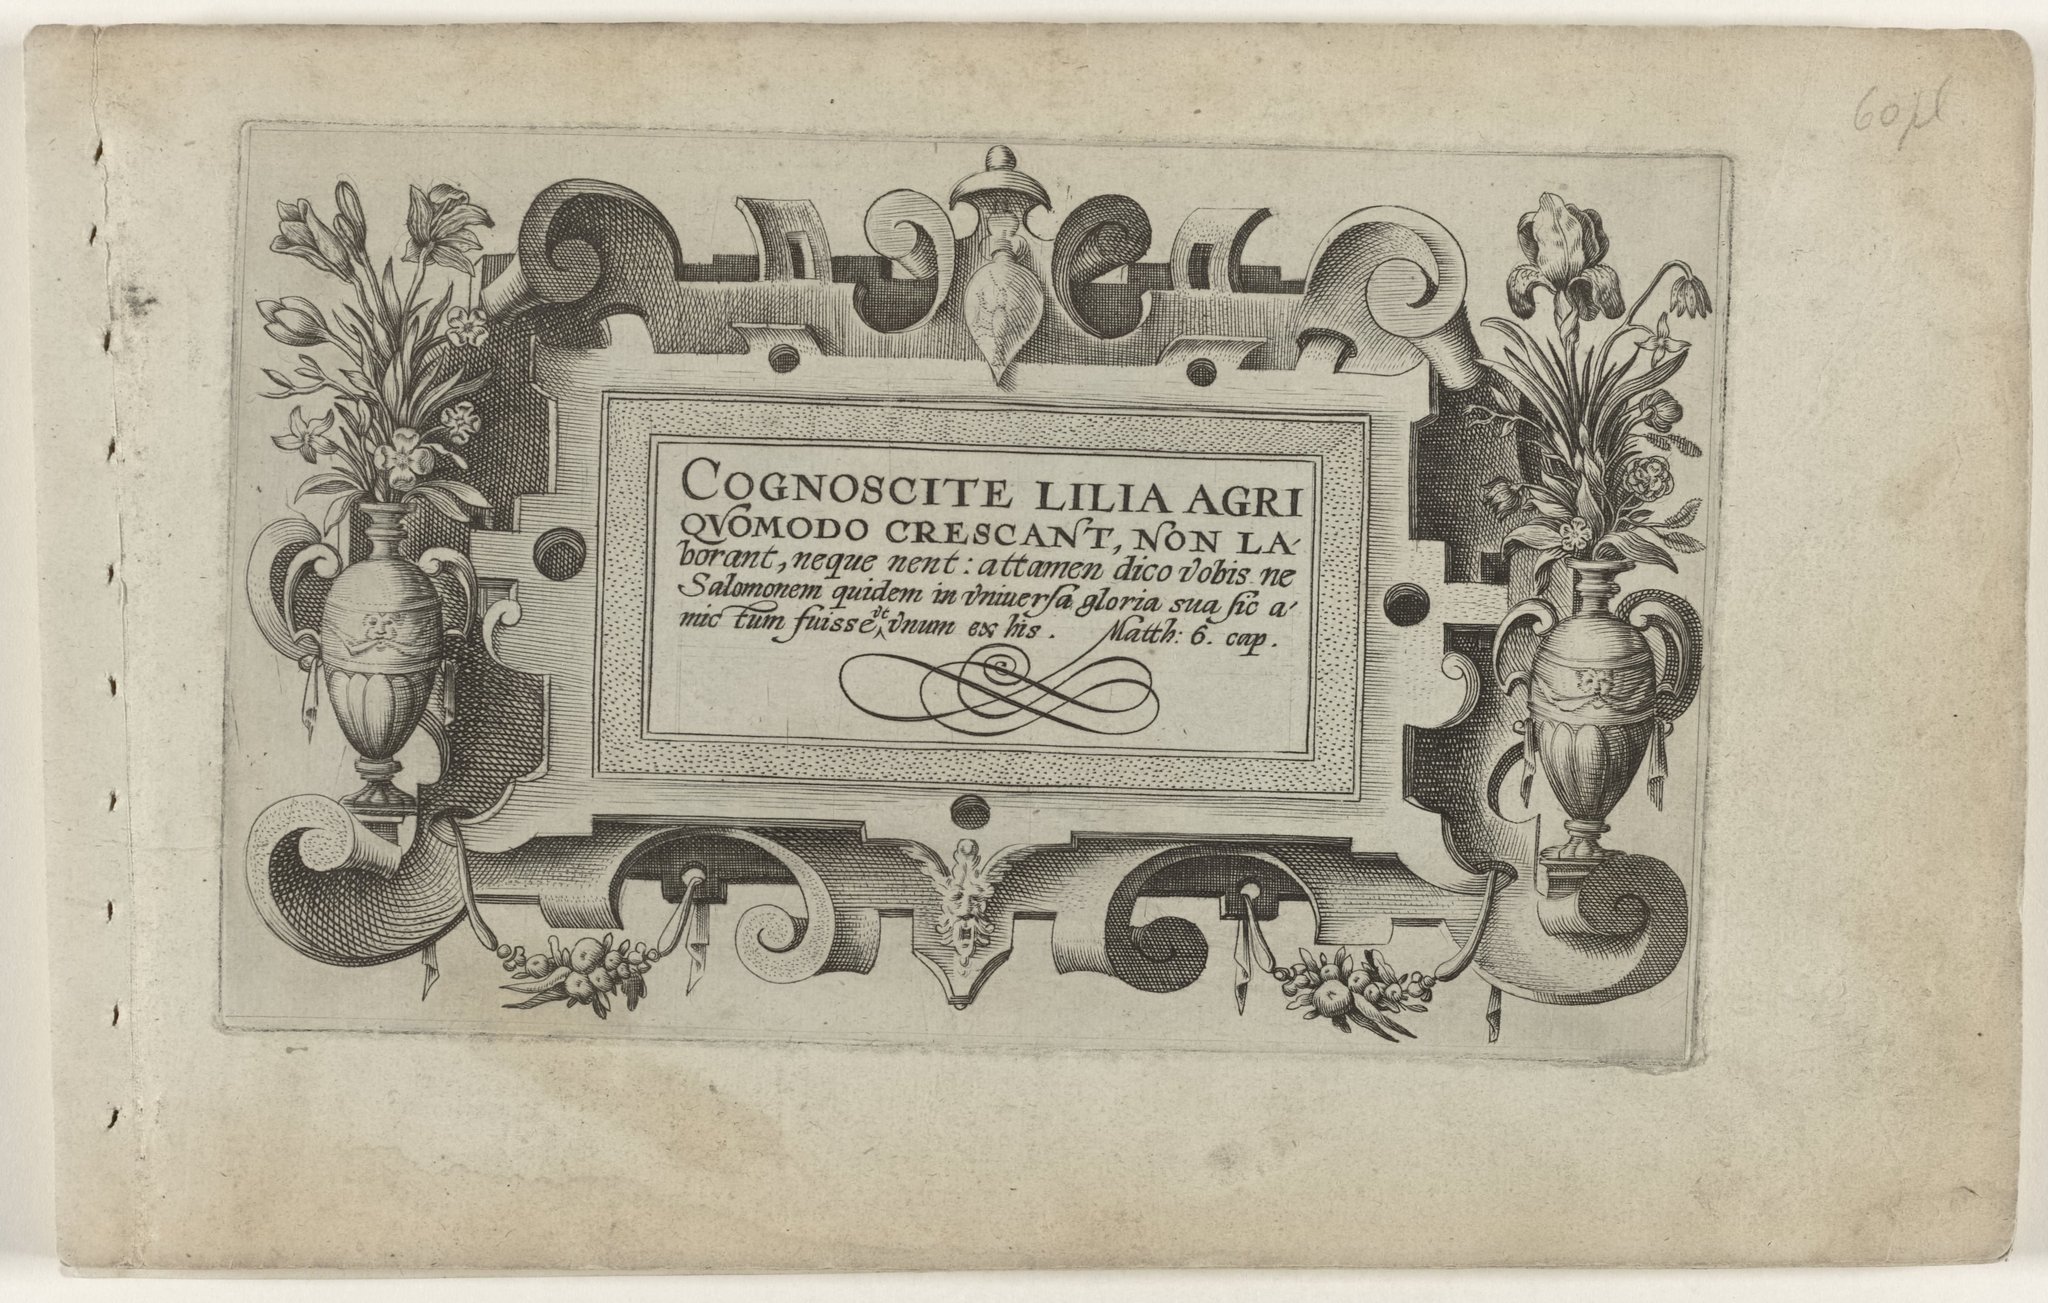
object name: titelprent, frontispice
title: Title Page and Eleven Prints of Flowers, Plants, and Fruit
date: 1600-1604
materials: paper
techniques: engraving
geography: cologne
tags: flowers, scrollwork, strapwork ~ ornament, vase ~ ornament, title-page, botany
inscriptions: collector's mark: Lugt 2228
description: These twelve sheets are proof impressions for a series of 61 prints with illustrations of flowers, plants, and fruit, combined with small depictions of animals. The plants are rendered with great botanical accuracy. Generally a utilitarian plant is set next to an ornamental one cultivated for its beauty. The title Cognoscite lilia agri refers to the words spoken by Jesus: ‘Consider the lilies of the field, how they grow’.